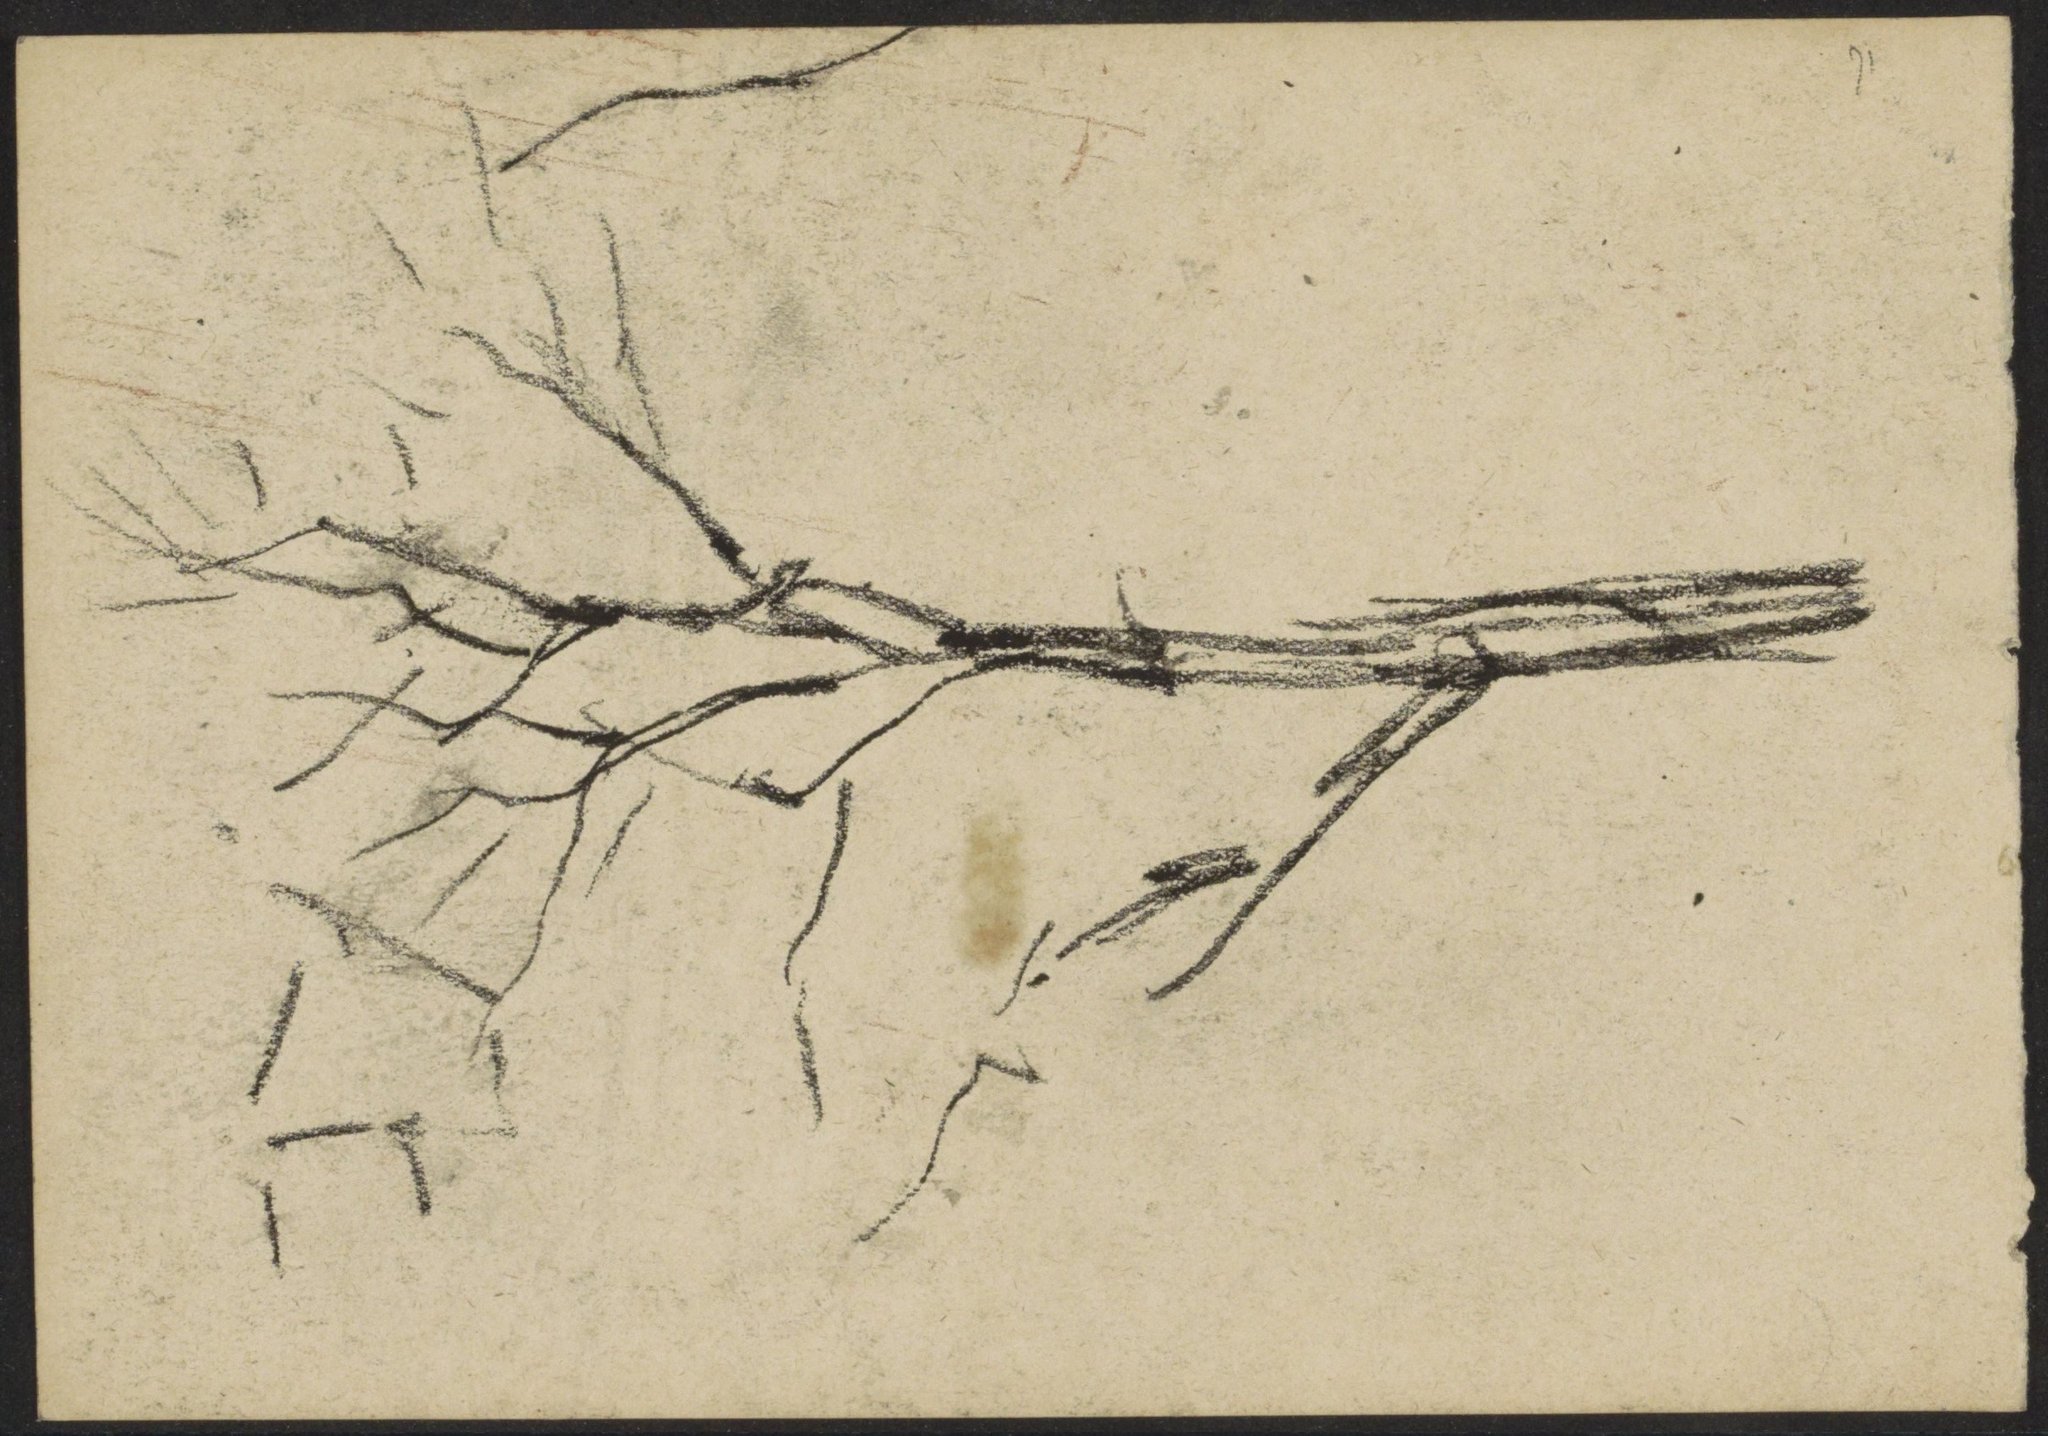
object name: sketchbook leaf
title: Boom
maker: willem witsen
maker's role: draughtsman, painter, print maker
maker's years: 1860-1923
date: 1870-1923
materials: chalk, paper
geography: amsterdam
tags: trees